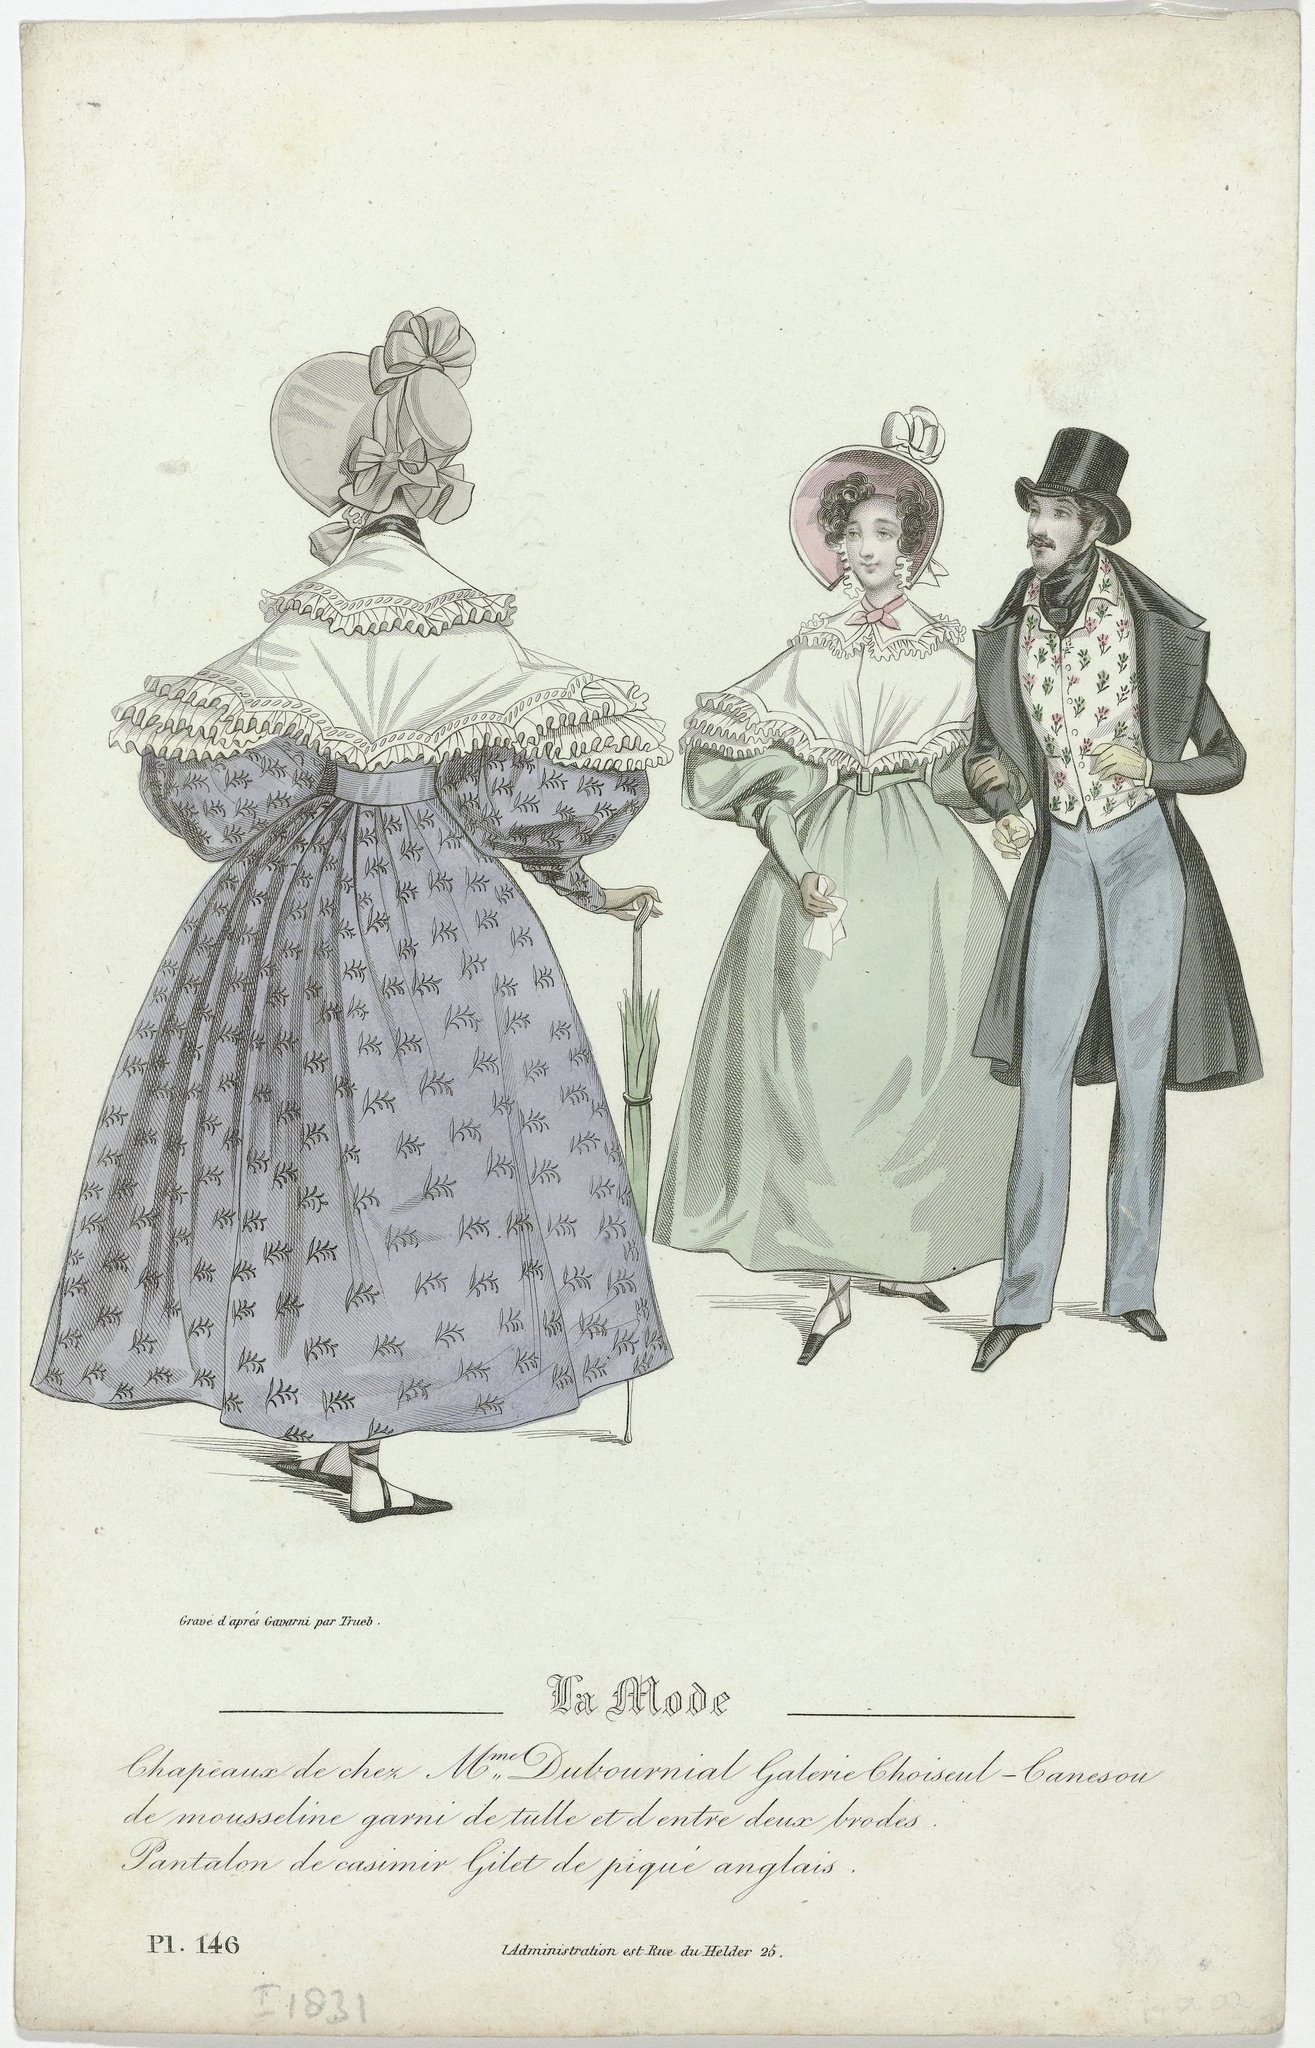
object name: fashion print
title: La Mode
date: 1831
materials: paper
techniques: etching, hand coloring, engraving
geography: paris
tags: clothing for the upper part of the body (vest) (+ men's clothes), handkerchief (+ women's clothes), neck-gear ~ clothing (+ men's clothes), embroidery (ornamentation) (+ women's clothes), clothing for the upper part of the body: blouse (+ women's clothes), trousers, breeches, etc. (pantalon) (+ men's clothes), coat (+ men's clothes), fashion plates, head-gear: hat (+ women's clothes), dress, gown (+ women's clothes), gloves, mittens, etc. (+ men's clothes), arm in arm (lovers), parasol, sunshade (+ women's clothes)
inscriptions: title: ‘La Mode.’, address: ‘L'Administration est Rue du Helder 25.’, caption: ‘Chapeau de chez M"me Dubournial Galerie Choiseul - Canesou de mousseline garni de tulle et d entre deux brodes. Pantalon de casimir Gilet de piqué anglais.’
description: On launching his society magazine La Mode (1829- 1955), the publisher Girardin criticized other fashion magazines for their ‘stiff, mechanical mannequins’. He wanted pictures that were more modern and animated. In illustrator Paul Gavarni, who had a reputation as the best-dressed man in Paris, he found just the right man to put a fresh spin on the fashion plate and to make the stiff ‘mannequins’ come to life.